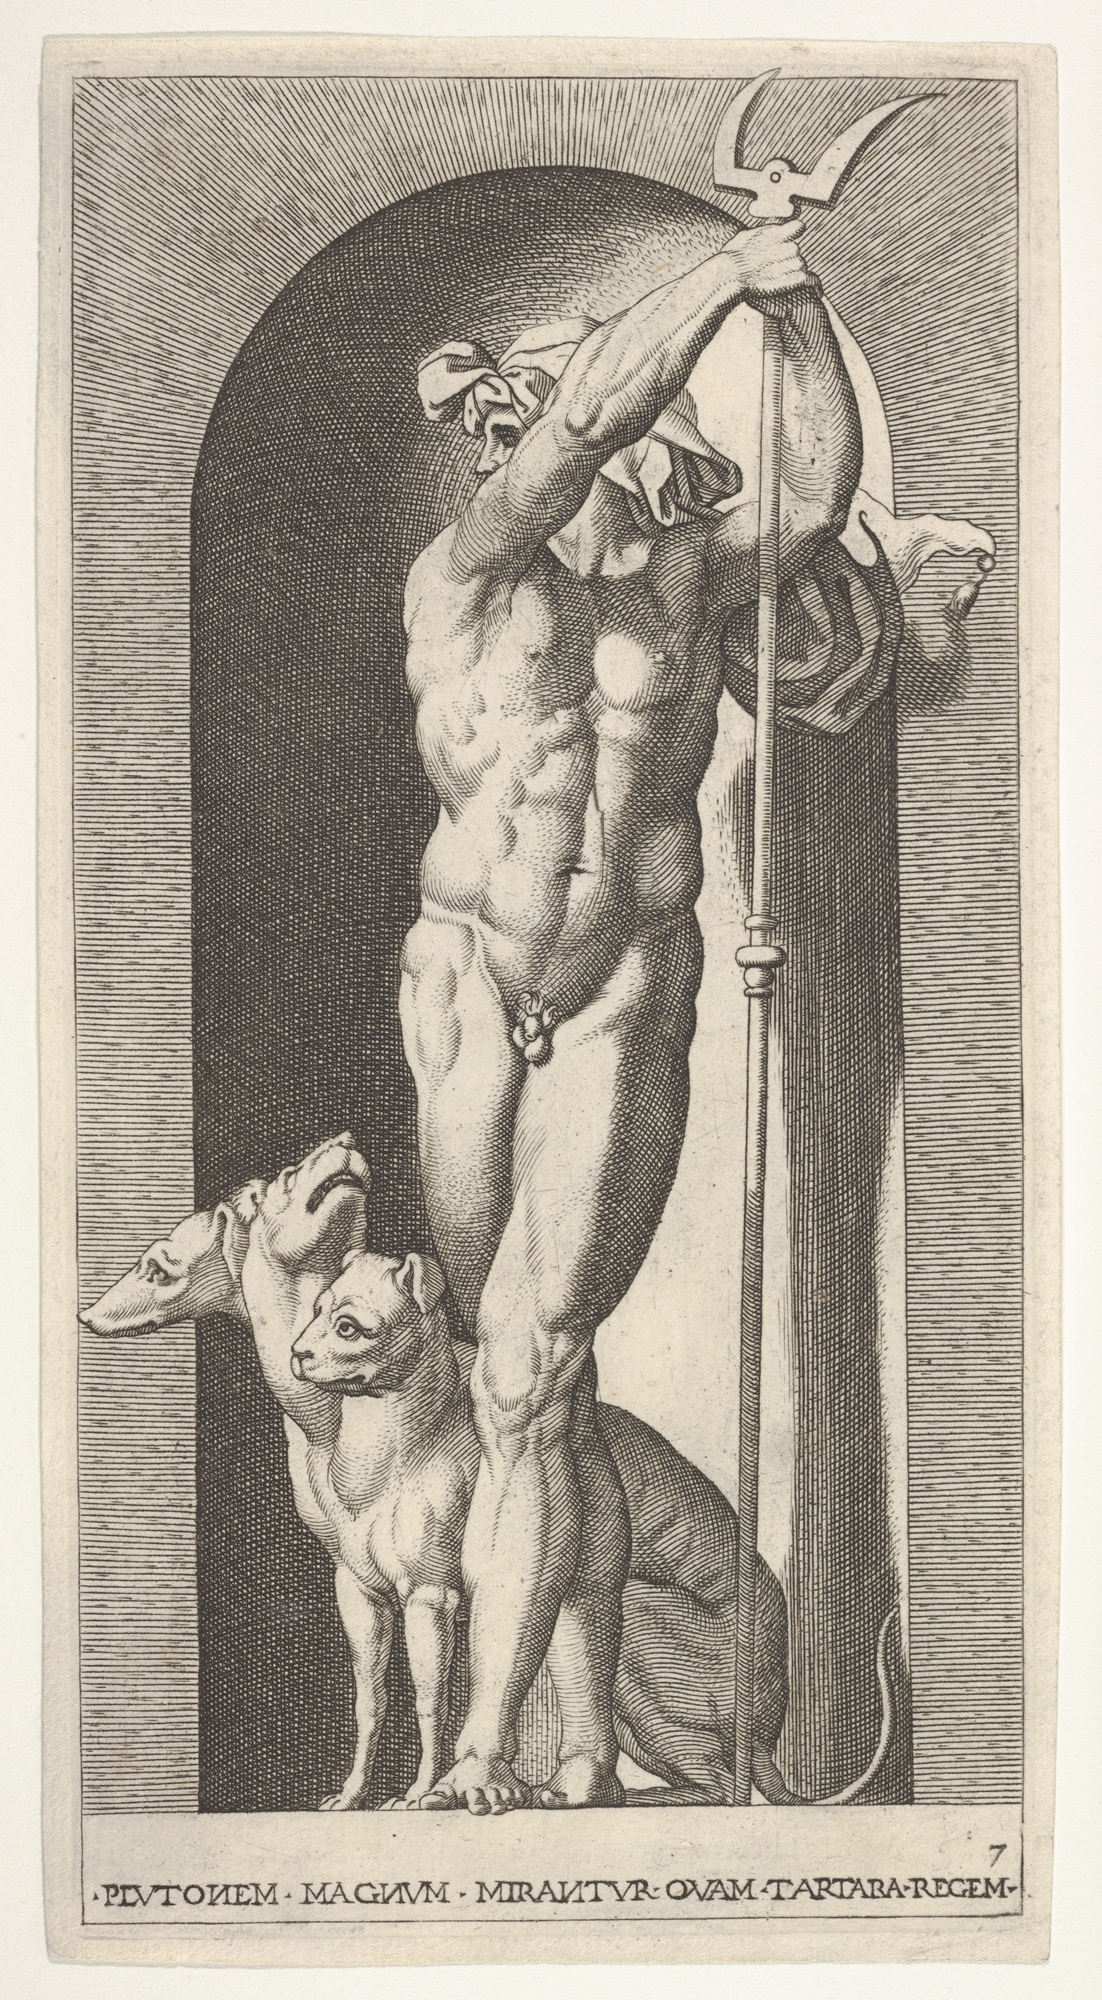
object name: print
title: Plate 7: Pluto in a niche, holding a bident, with Cerberus next to him, from a series of mythological gods and goddesses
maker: giovanni jacopo caraglio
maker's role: artist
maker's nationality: italian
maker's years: 1500-1565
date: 1526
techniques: etching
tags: male nudes,dogs,pluto